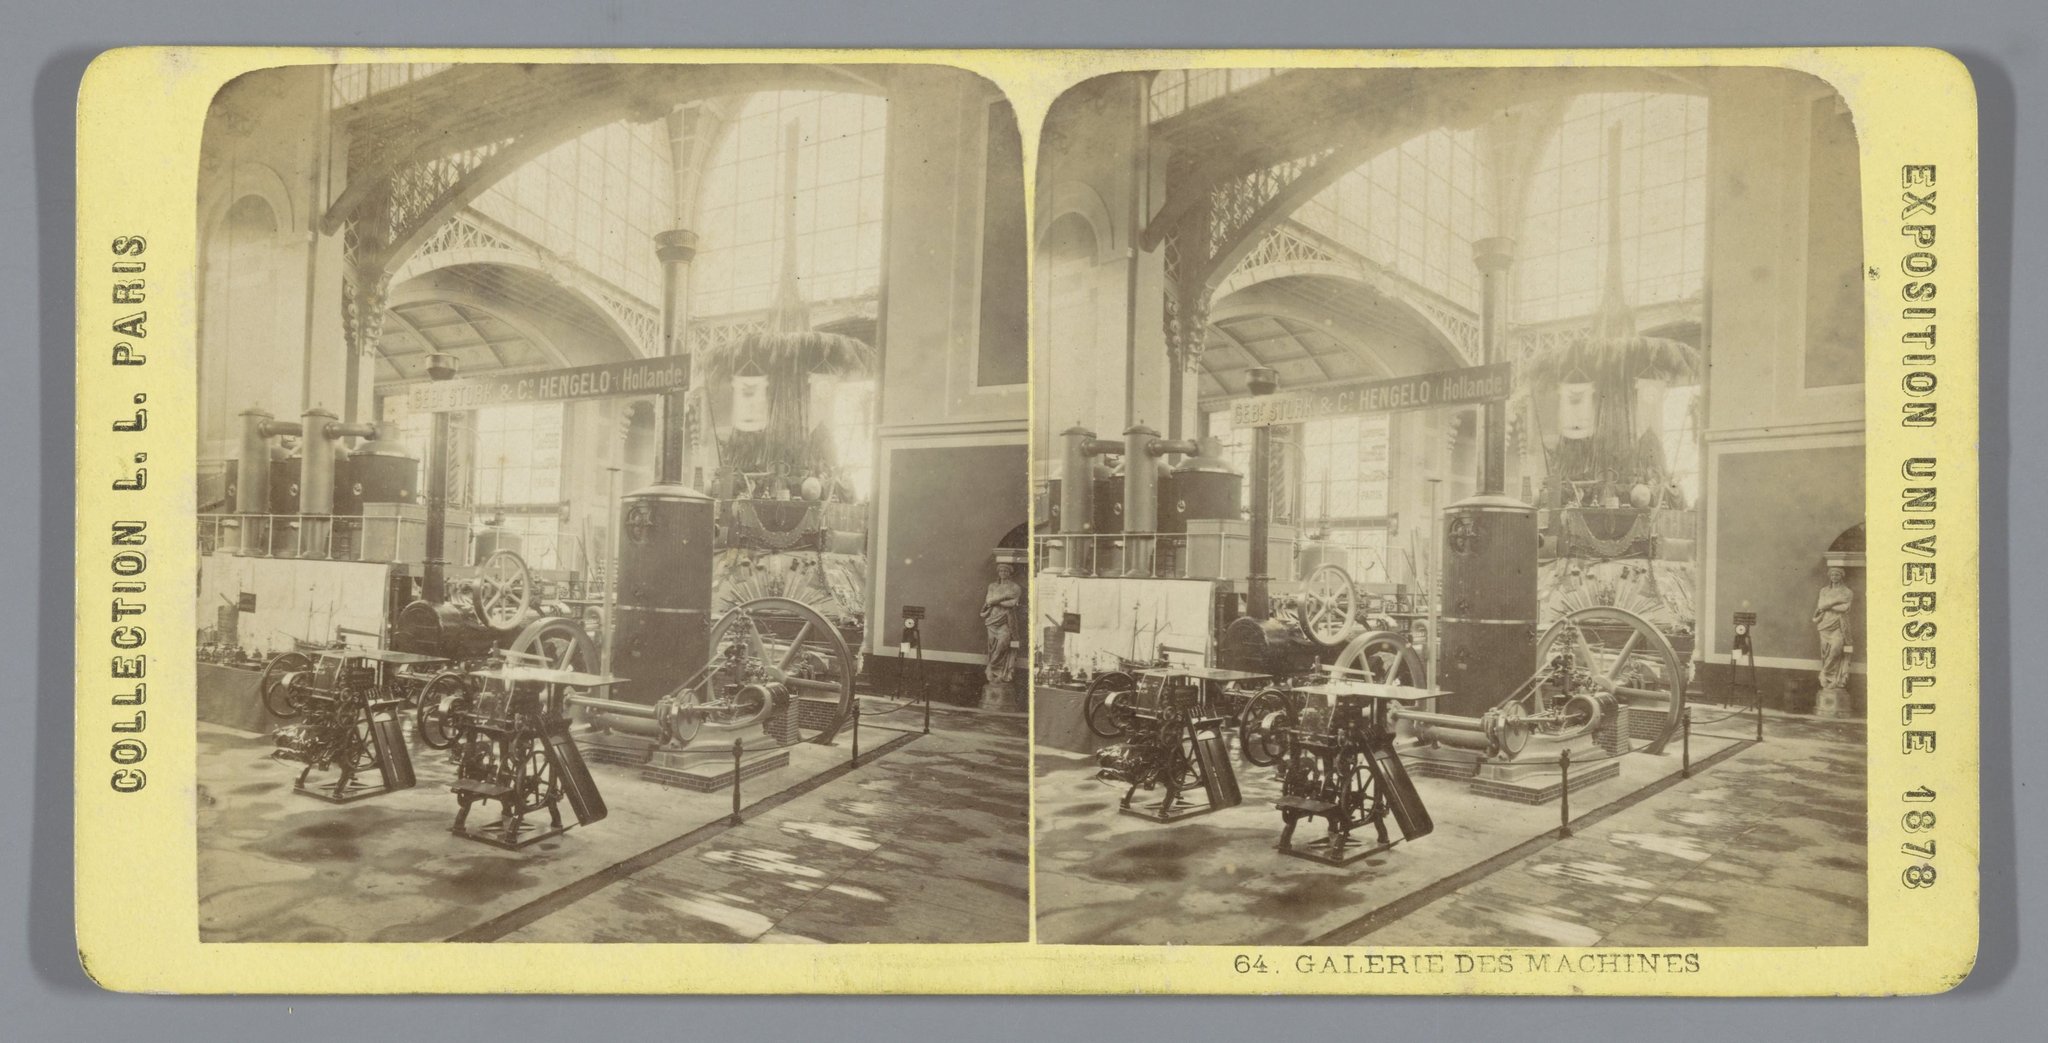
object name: stereograph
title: Machinehal op de Wereldtentoonstelling van 1878, met machines van de Gebr. Stork & Co uit Hengelo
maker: Anonymous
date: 1878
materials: cardboard, paper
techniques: albumen print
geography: paris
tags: machine driven by steam, world fair, world exhibition, paris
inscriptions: number: ‘64.’